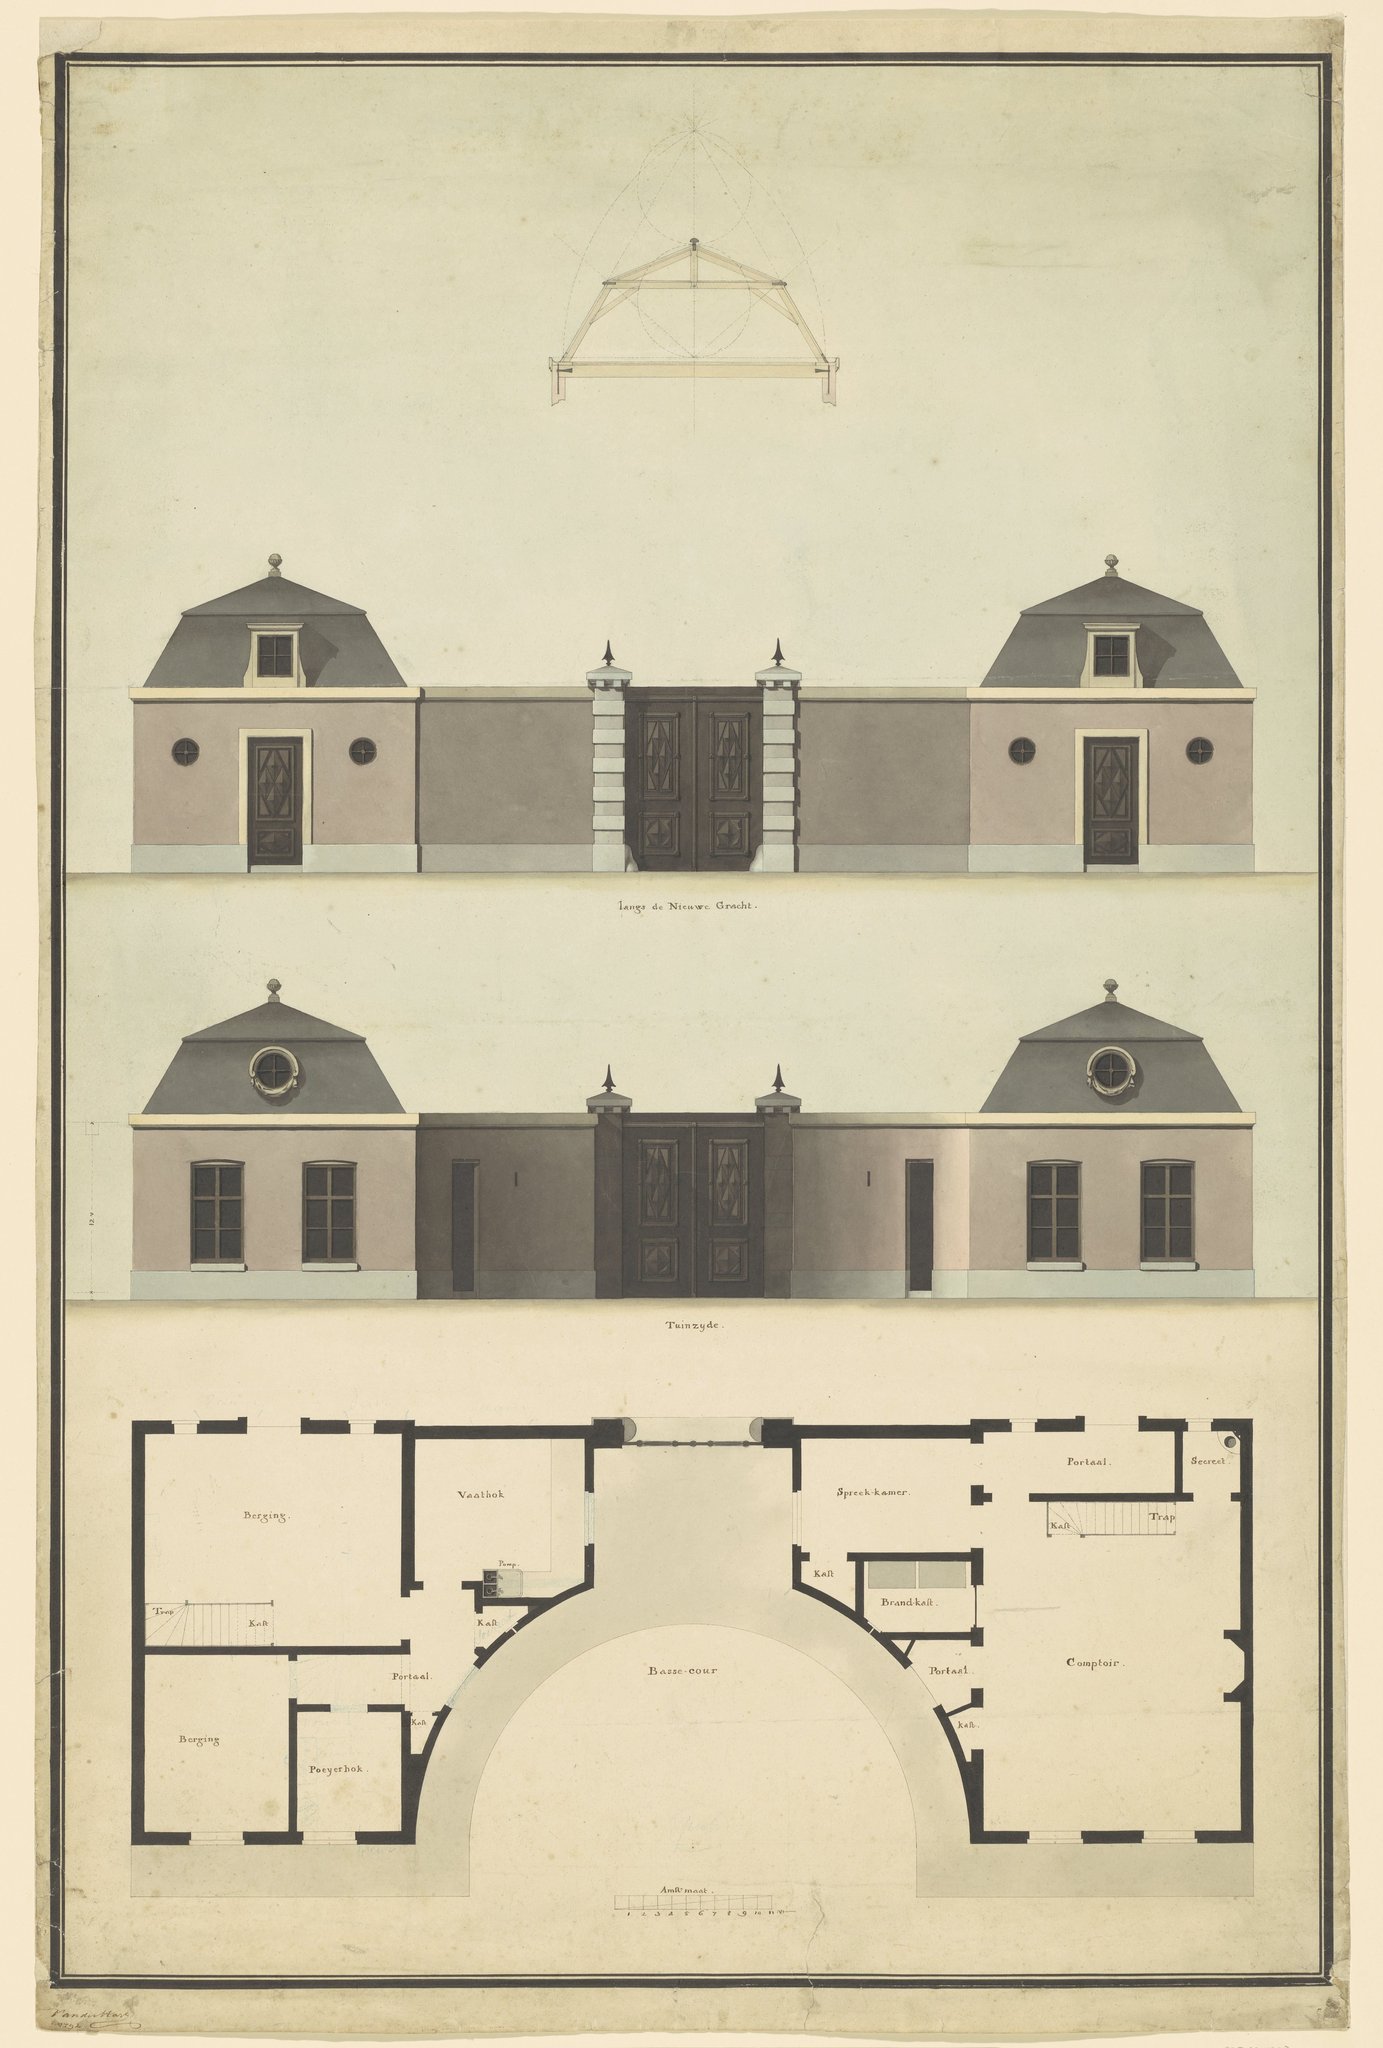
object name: drawing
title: Ontwerp voor een poortgebouw annex kantoor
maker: abraham van der hart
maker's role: draughtsman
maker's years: 1747-1820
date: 1792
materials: ink, paper, watercolor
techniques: brush, pen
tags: architectural design or model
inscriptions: date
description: Plattegrond en gevelopstanden aan de Nieuwe Gracht en de Tuinzijde. Met schaalverdeling. Mogelijk voor het Huis Kops, Nieuwegracht 74, Haarlem.